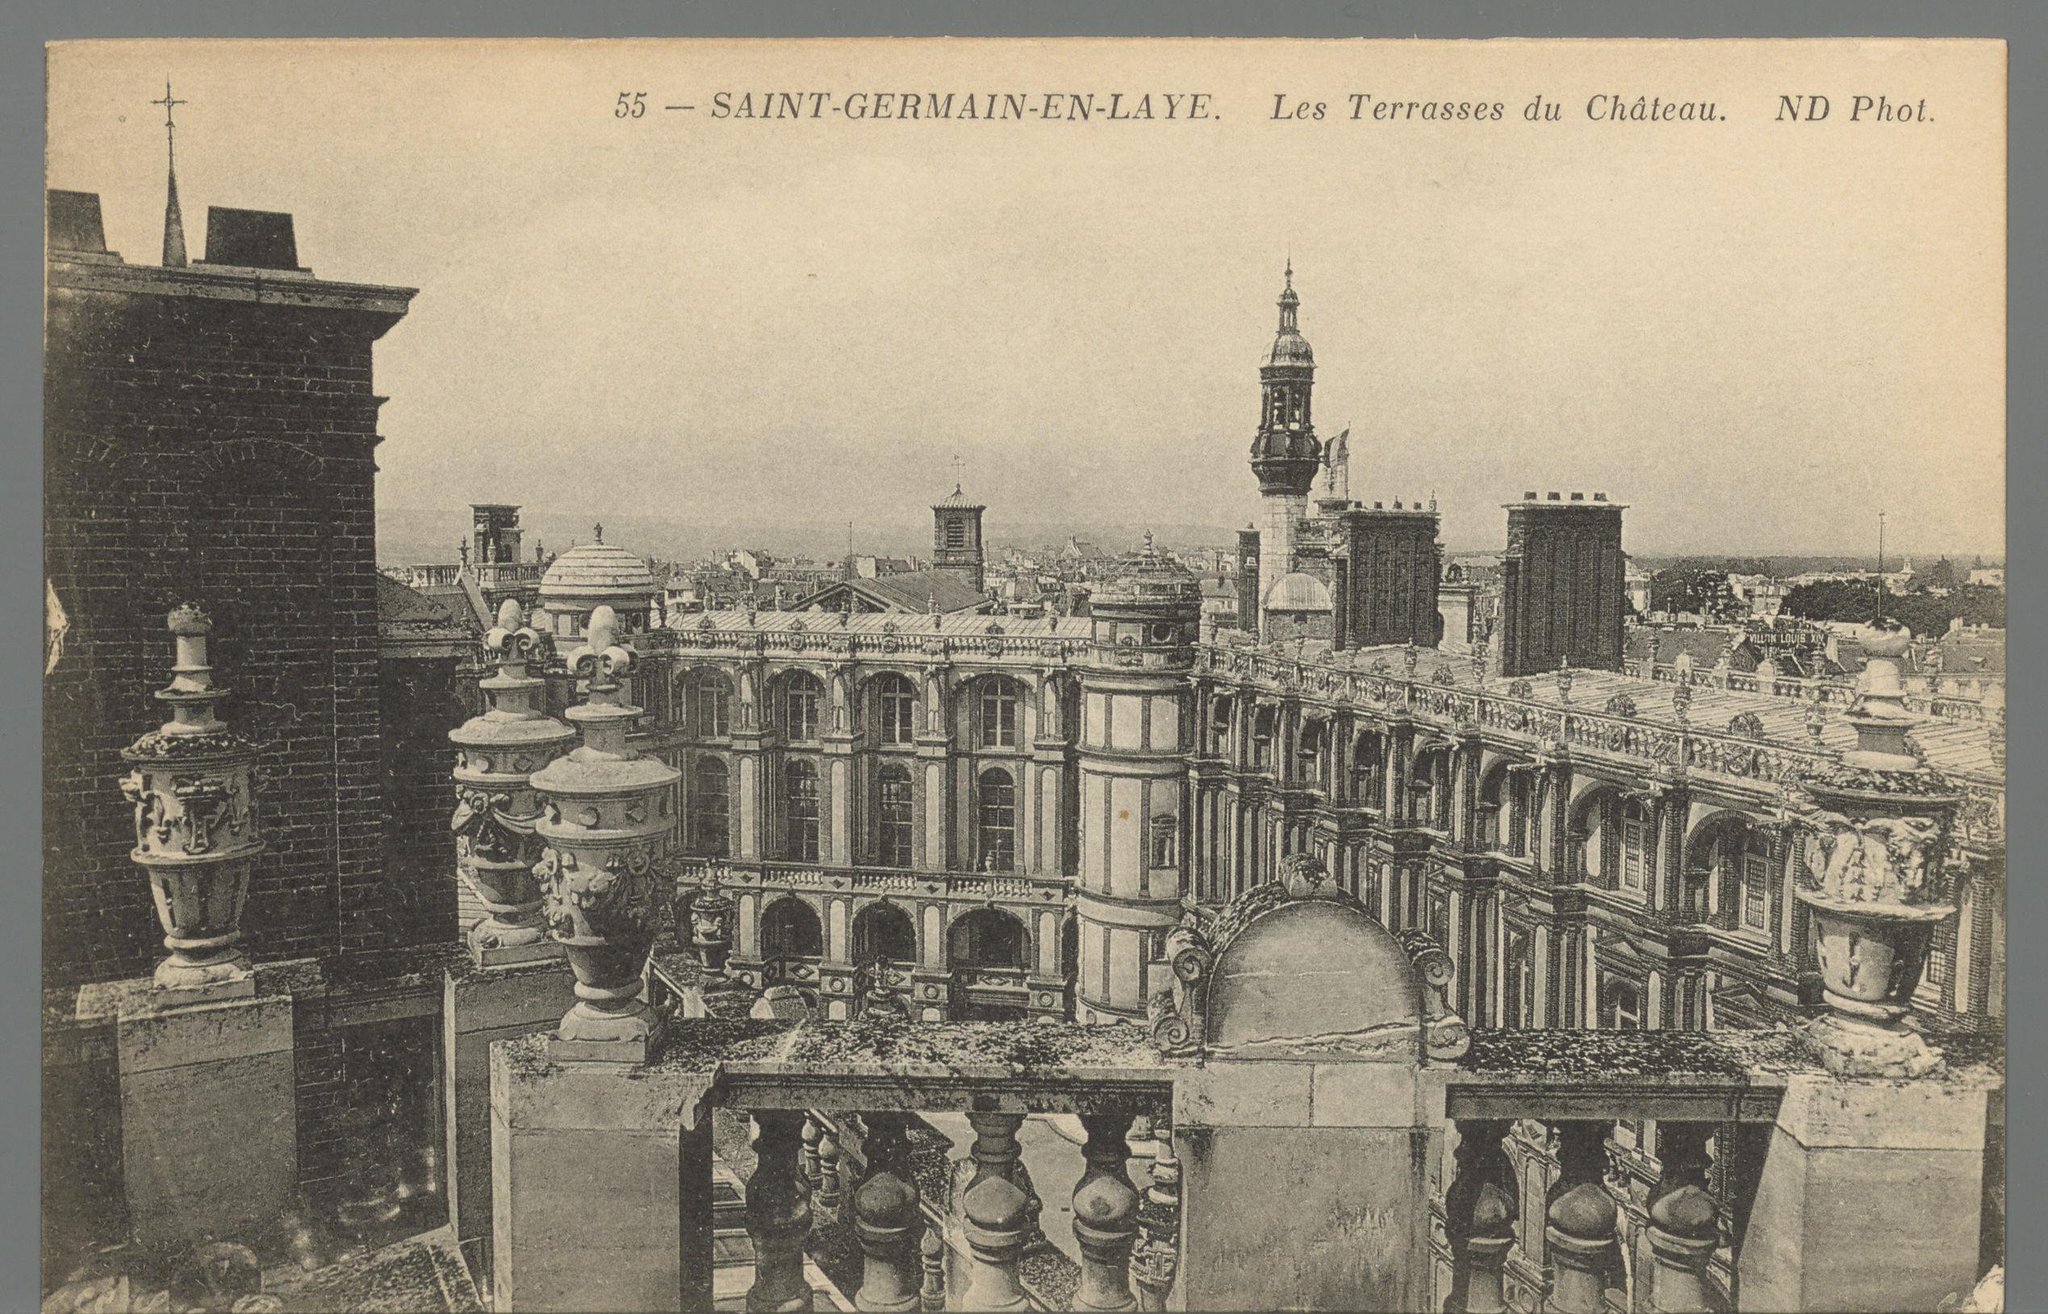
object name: ansichtkaart, prentbriefkaart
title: Saint-Germain-en-Laye. Les Terrasses du Château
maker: Anonymous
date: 1903-1918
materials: cardboard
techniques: photograph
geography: paris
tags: castle, permanent exhibition, museum, exterior ~ representation of a building